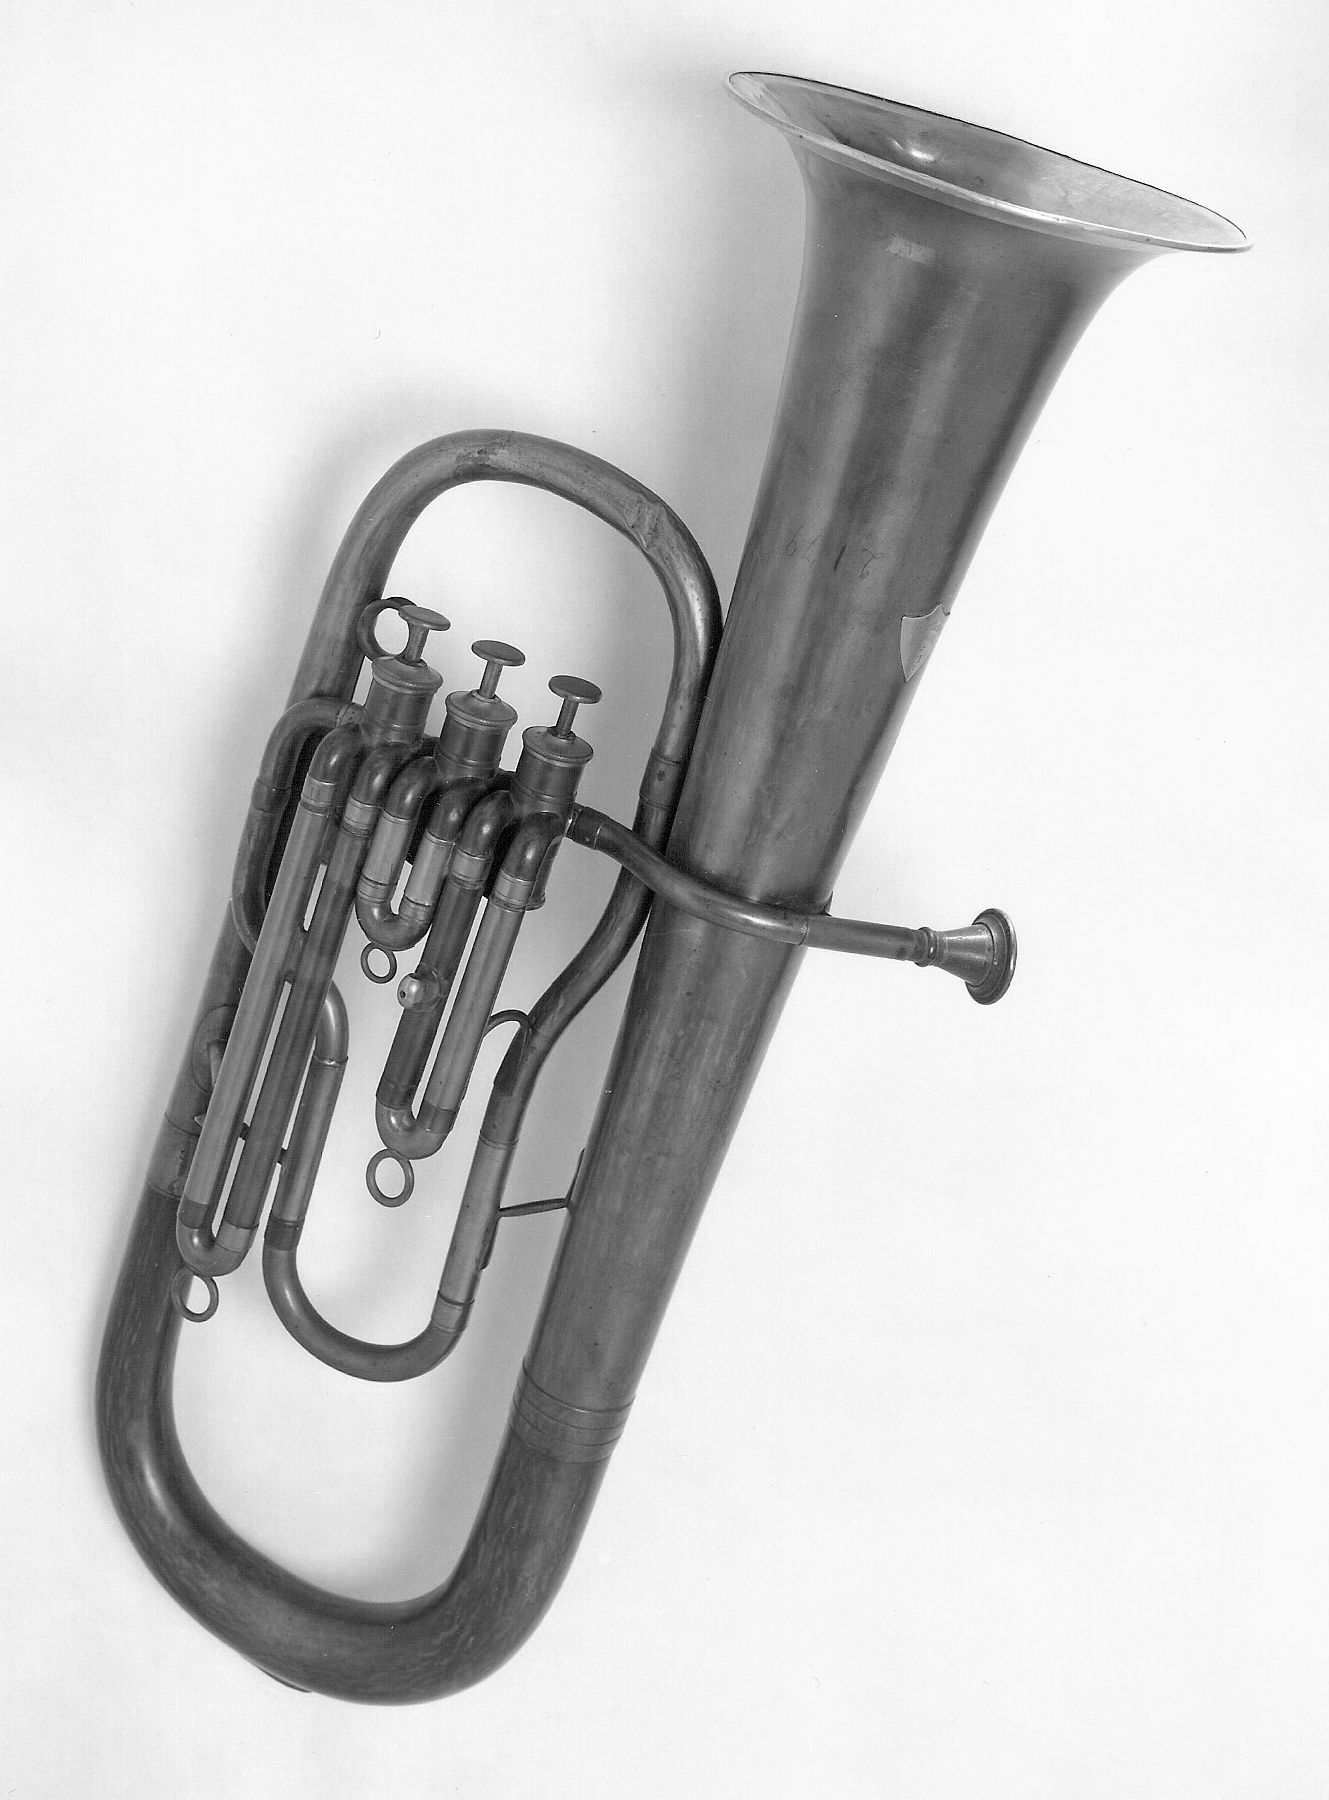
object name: soprano saxhorn in b flat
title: Baritone Saxhorn in B-flat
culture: american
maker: m. slater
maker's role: maker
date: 1865-1868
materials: brass, nickel, silver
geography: united states